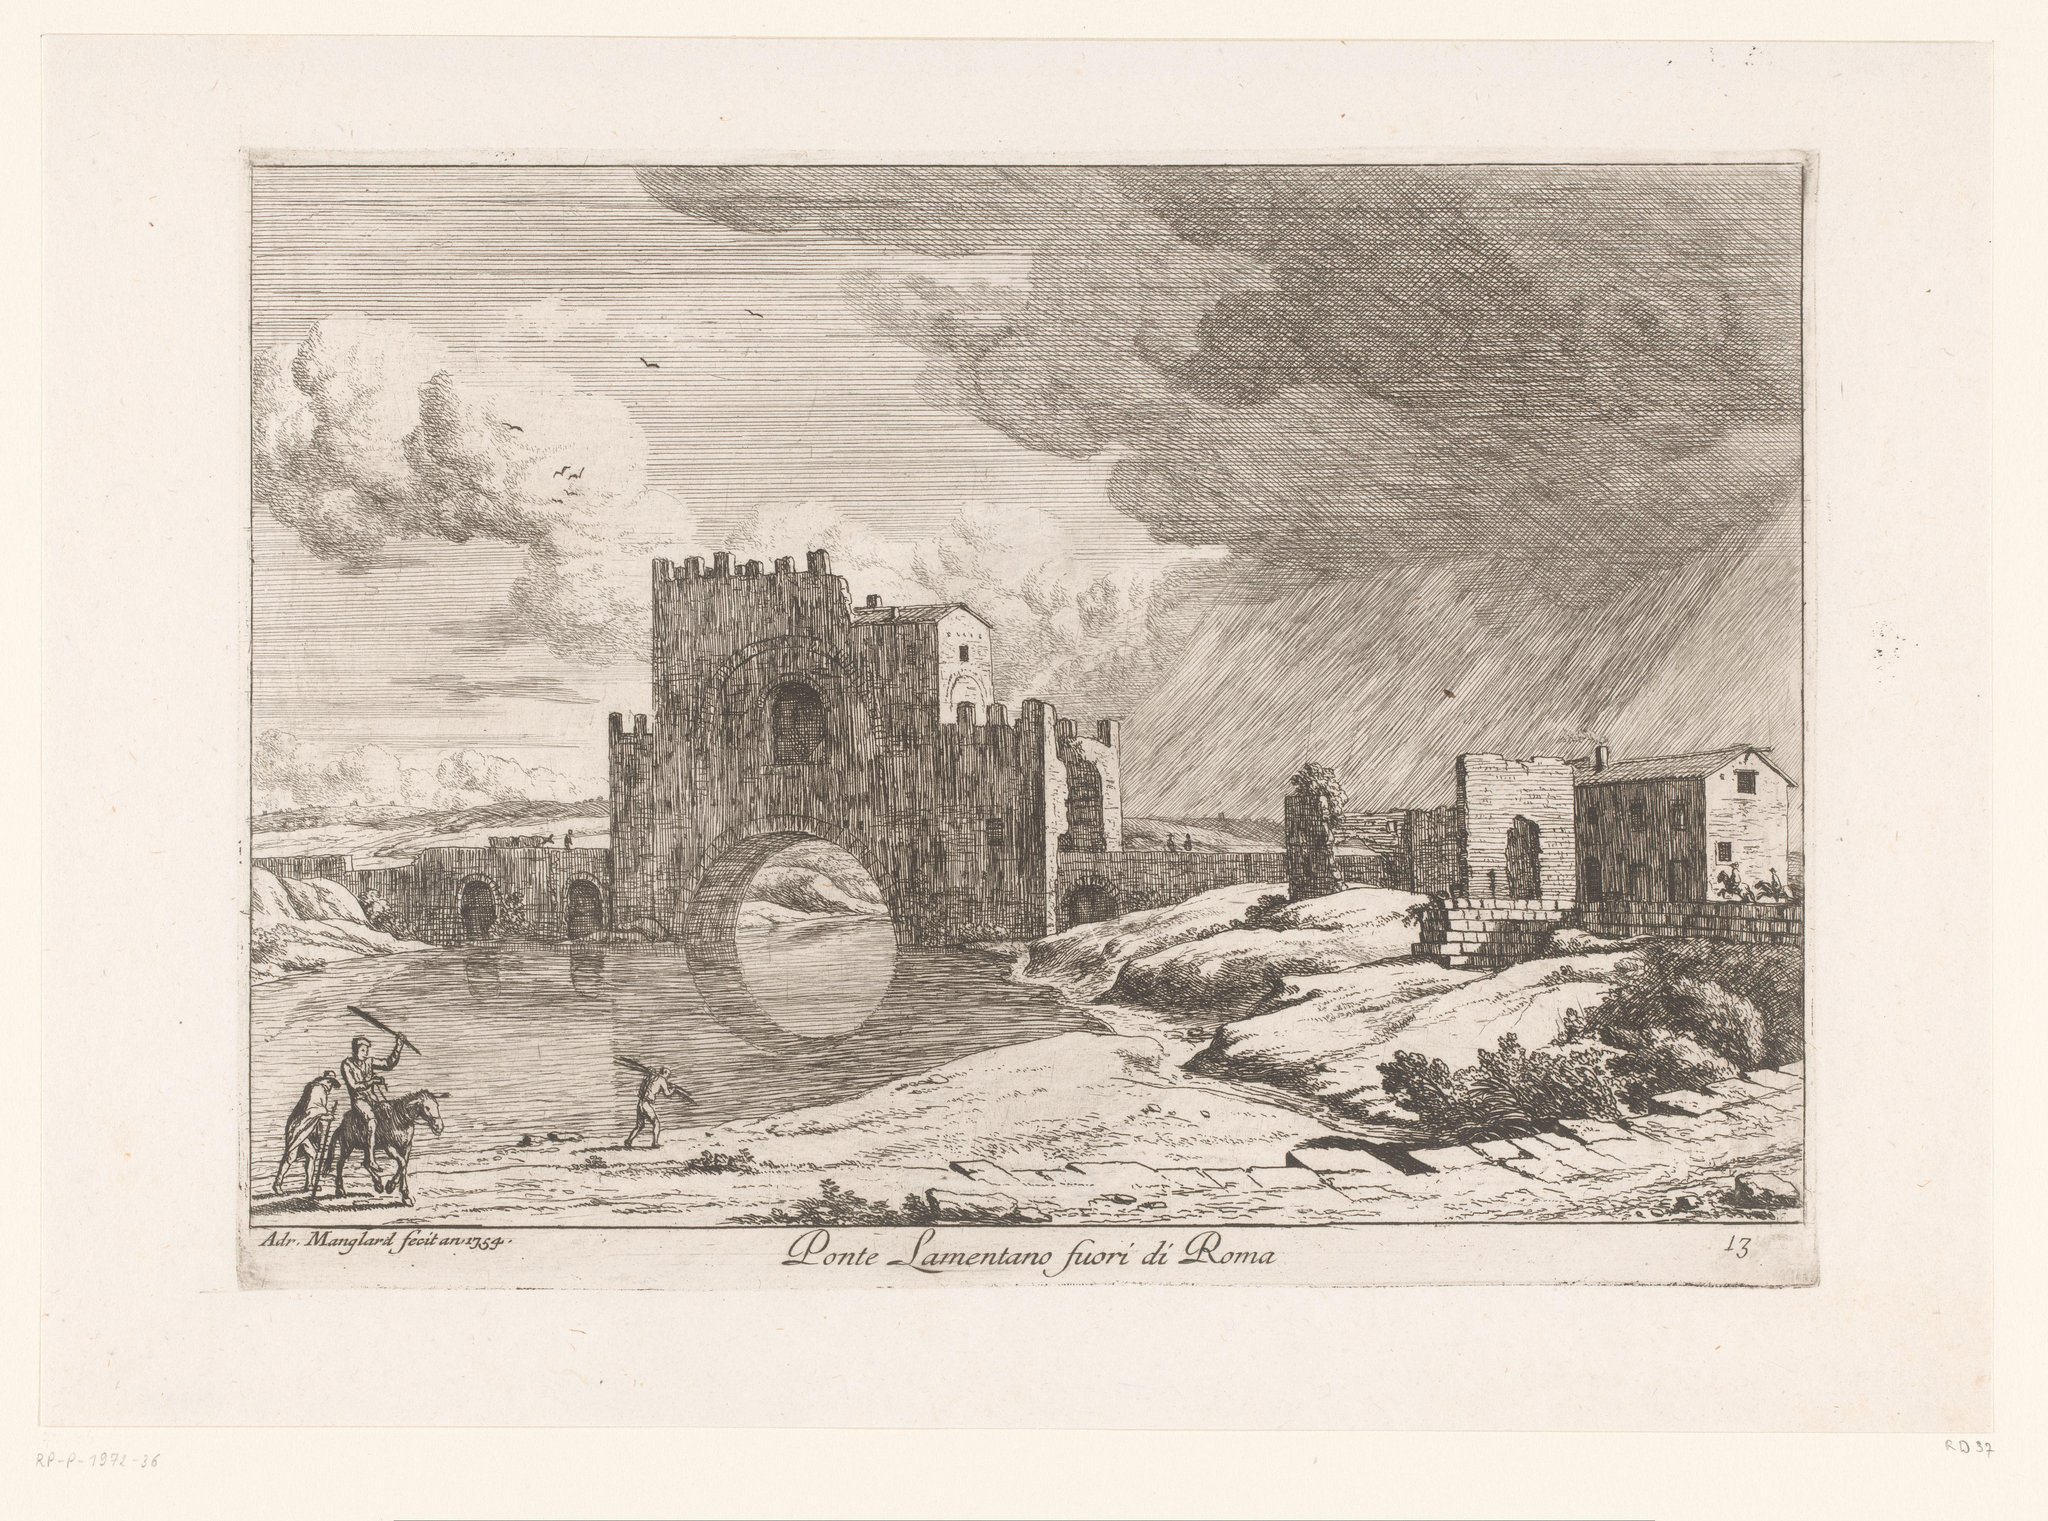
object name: print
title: Ponte Lamentano fuori di Roma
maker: adrien manglard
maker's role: draughtsman, print maker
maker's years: 1695-1760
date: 1754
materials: paper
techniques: engraving, etching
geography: rome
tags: bridge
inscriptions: collector's mark: Lugt 4731, collector's mark: Lugt 2228, collector's mark: Lugt 2760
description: Deze prent is de dertiende uit een serie van minstens achttien prenten.